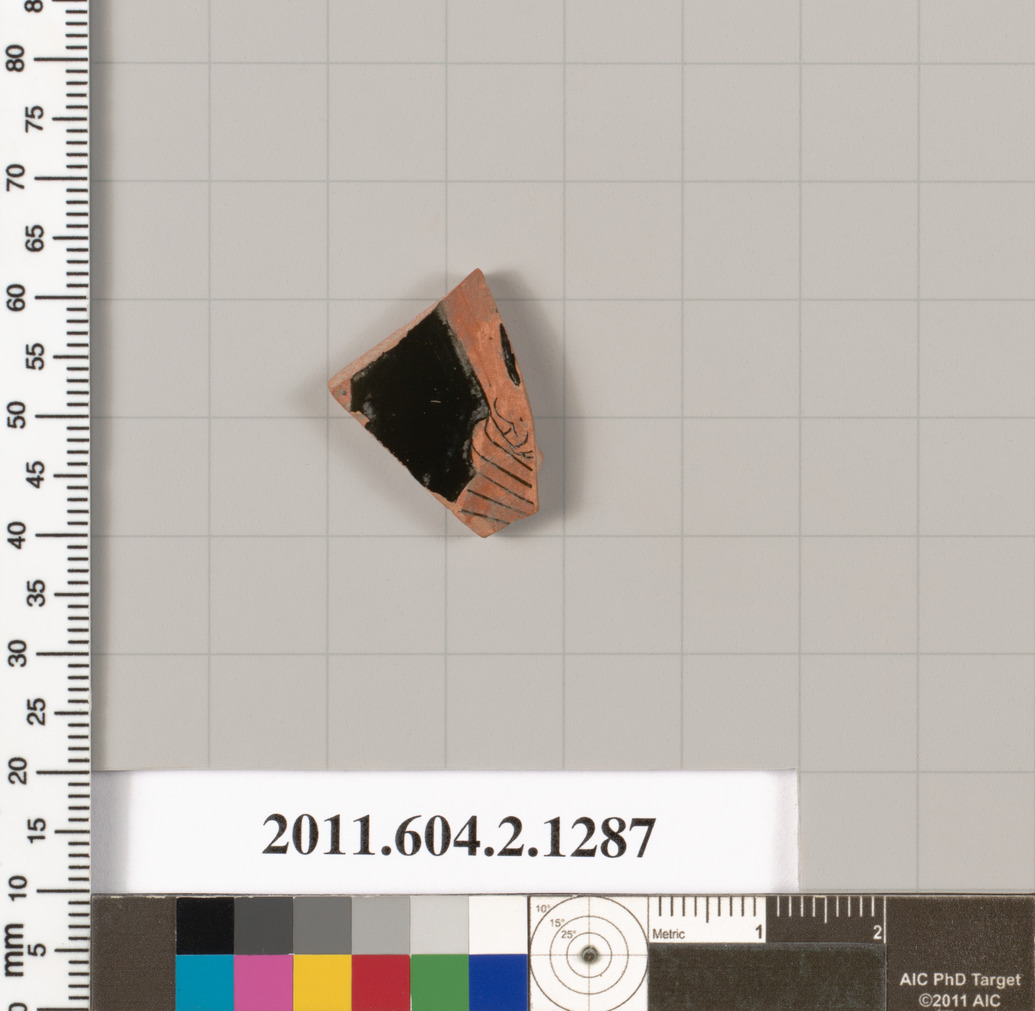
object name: skyphos fragment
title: Terracotta fragment of a skyphos (deep drinking cup)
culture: greek, attic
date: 475-451 BCE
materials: terracotta